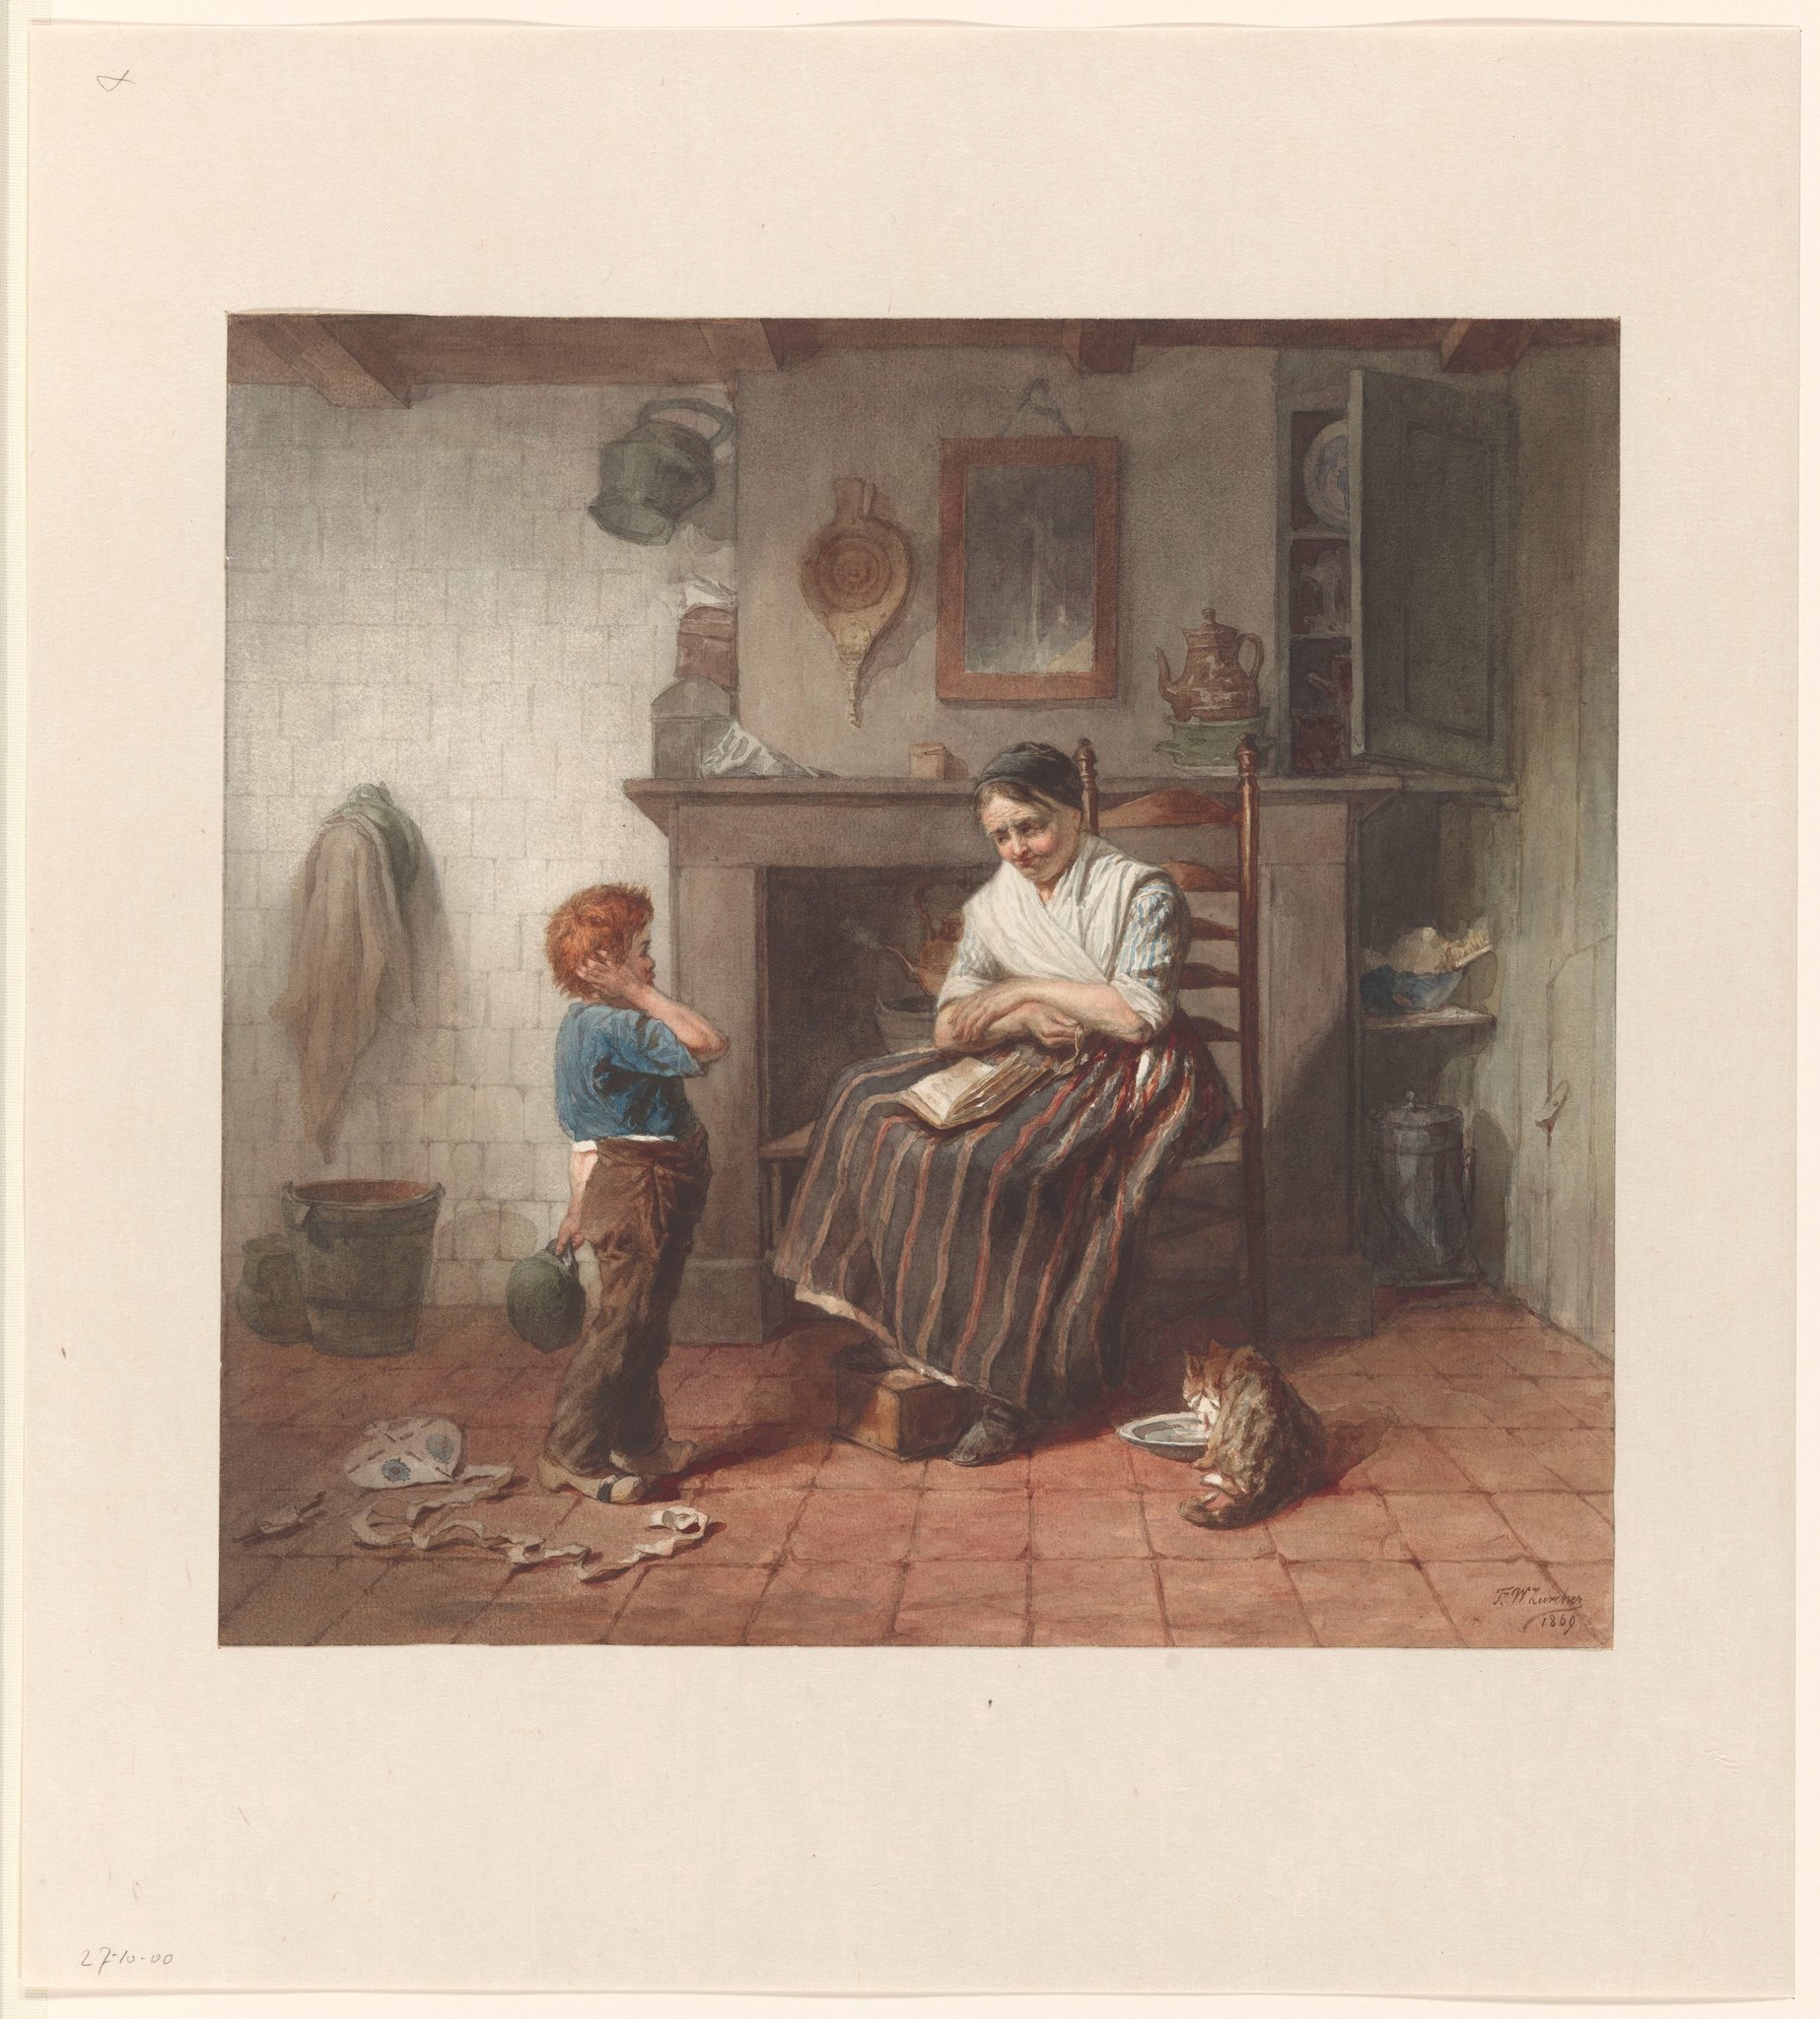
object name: watercolor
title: Interieur met een jongetje, een vlieger en een vrouw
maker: frederik willem zürcher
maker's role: draughtsman, print maker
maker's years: 1835-1894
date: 1869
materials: paper, pencil, watercolor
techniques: brush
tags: cat, boy (child between toddler and youth), female sex; woman, interior of the house, (flying a) kite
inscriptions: date: ‘1869’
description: Interieur met links een jongetje met rode haren en een vlieger op de grond, rechts een vrouw, die hem vermanend aankijkt.